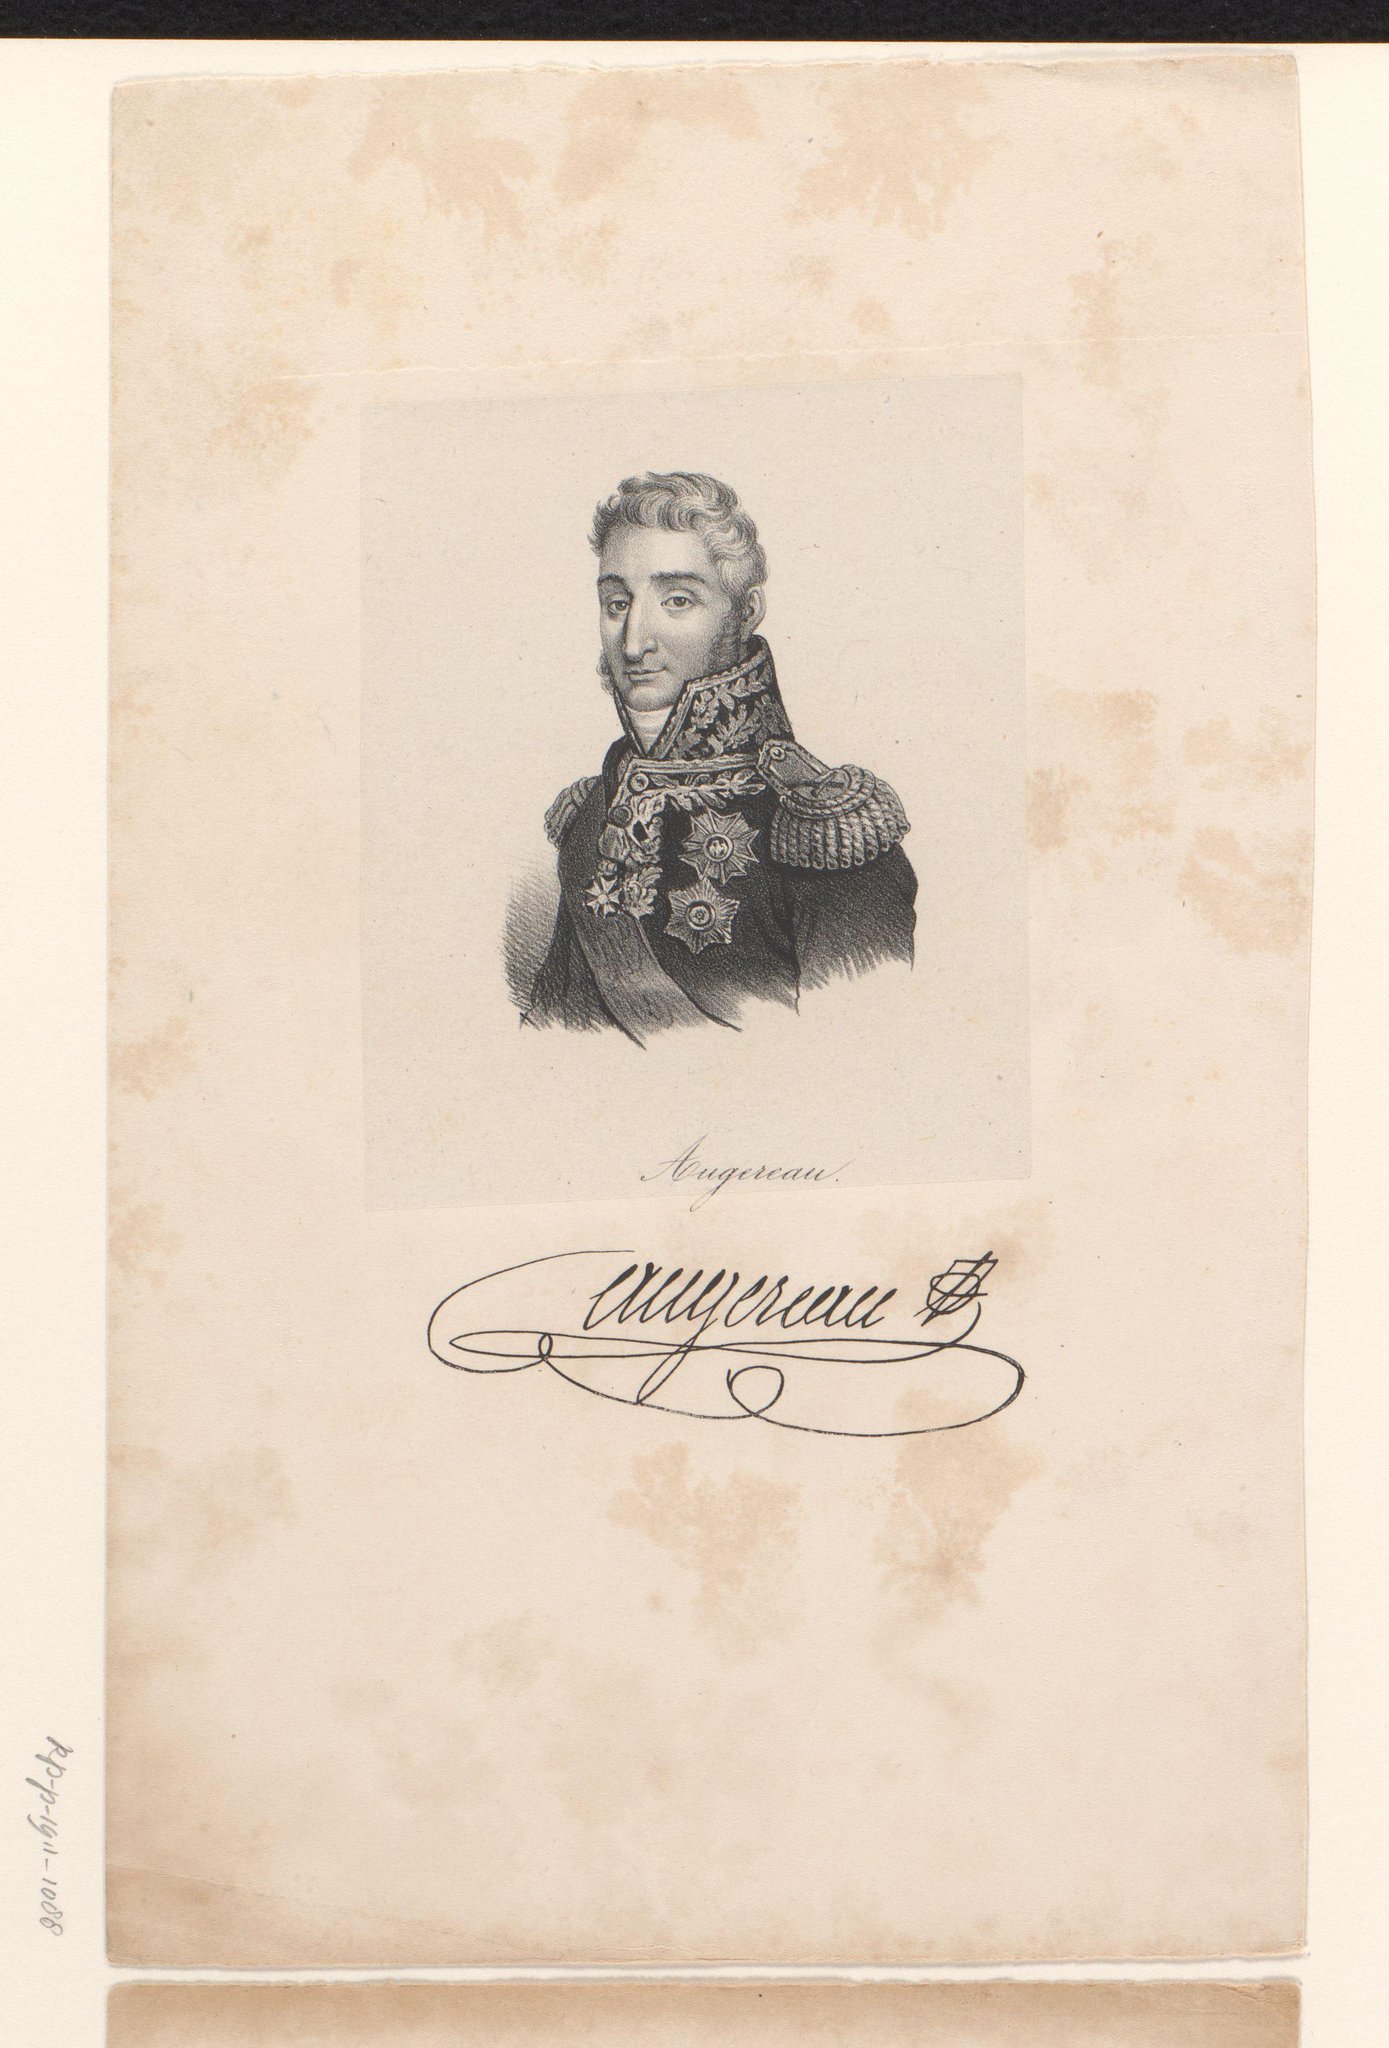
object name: print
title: Augereau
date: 1818-1842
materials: paper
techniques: lithograph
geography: paris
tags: politician, historical persons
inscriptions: collector's mark: Lugt 2228a